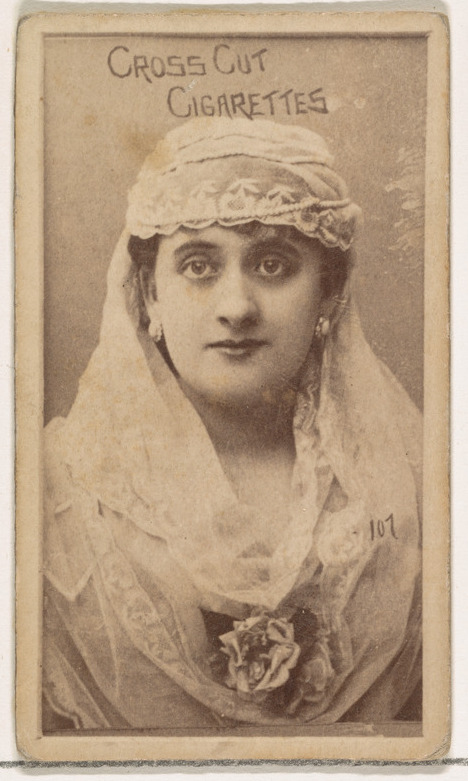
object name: print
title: Card Number 107, from the Actors and Actresses series (N145-1) issued by Duke Sons & Co. to promote Cross Cut Cigarettes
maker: w. duke, sons & co.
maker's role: publisher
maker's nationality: american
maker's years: 1870-1920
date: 1880-1889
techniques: albumen silver print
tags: portraits,women,actresses